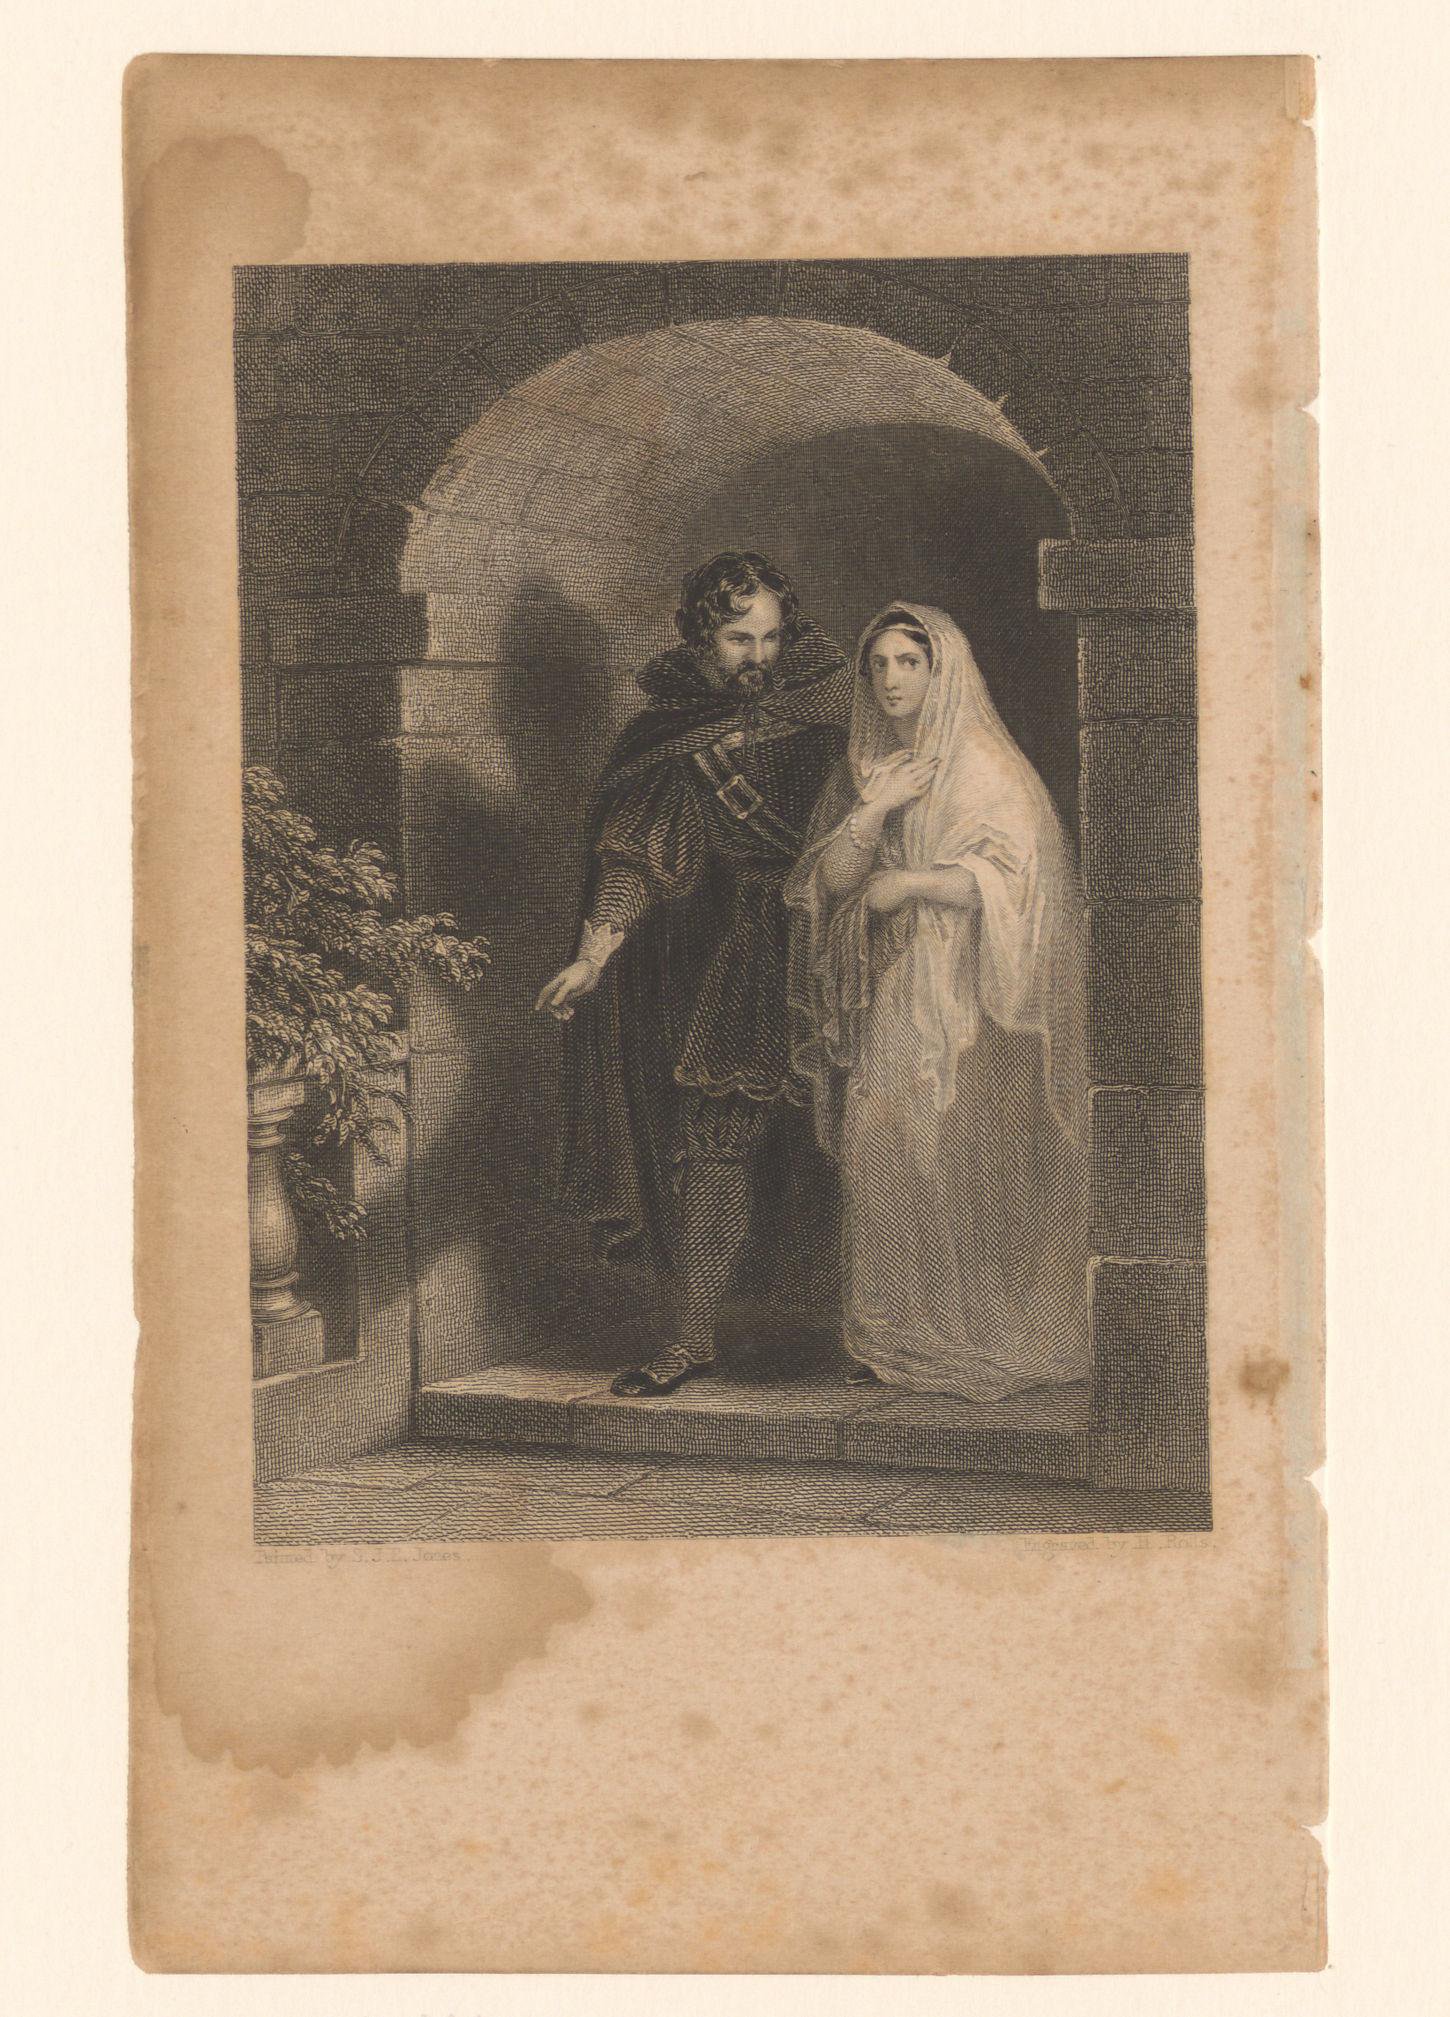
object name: print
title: Man begeleidt gesluierde vrouw naar buiten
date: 1841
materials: paper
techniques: engraving, etching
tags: freeing (an endangered fellow man)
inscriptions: annotation: ‘Aurora, 1841/ De Redding’, collector's mark: Lugt 2228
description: Prent gebruikt in: Aurora. Jaarboekje voor 1841. Den Haag: K. Fuhri, 1841.